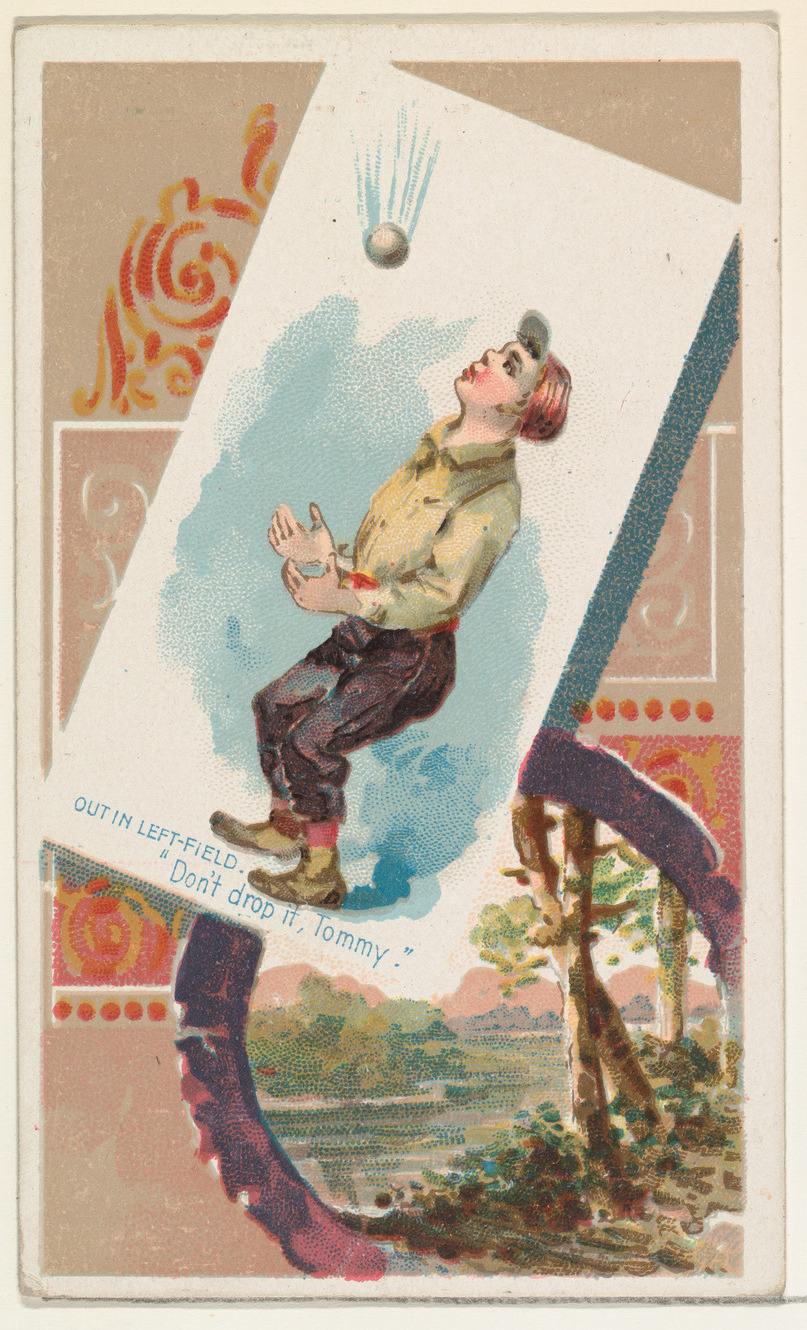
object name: print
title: Out in Left-Field, "Dont drop it, Tommy," from the Terrors of America set (N136) issued by Duke Sons & Co. to promote Honest Long Cut Tobacco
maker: w. duke, sons & co.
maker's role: publisher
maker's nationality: american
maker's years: 1870-1920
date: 1888-1889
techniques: color lithograph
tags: boys,profiles